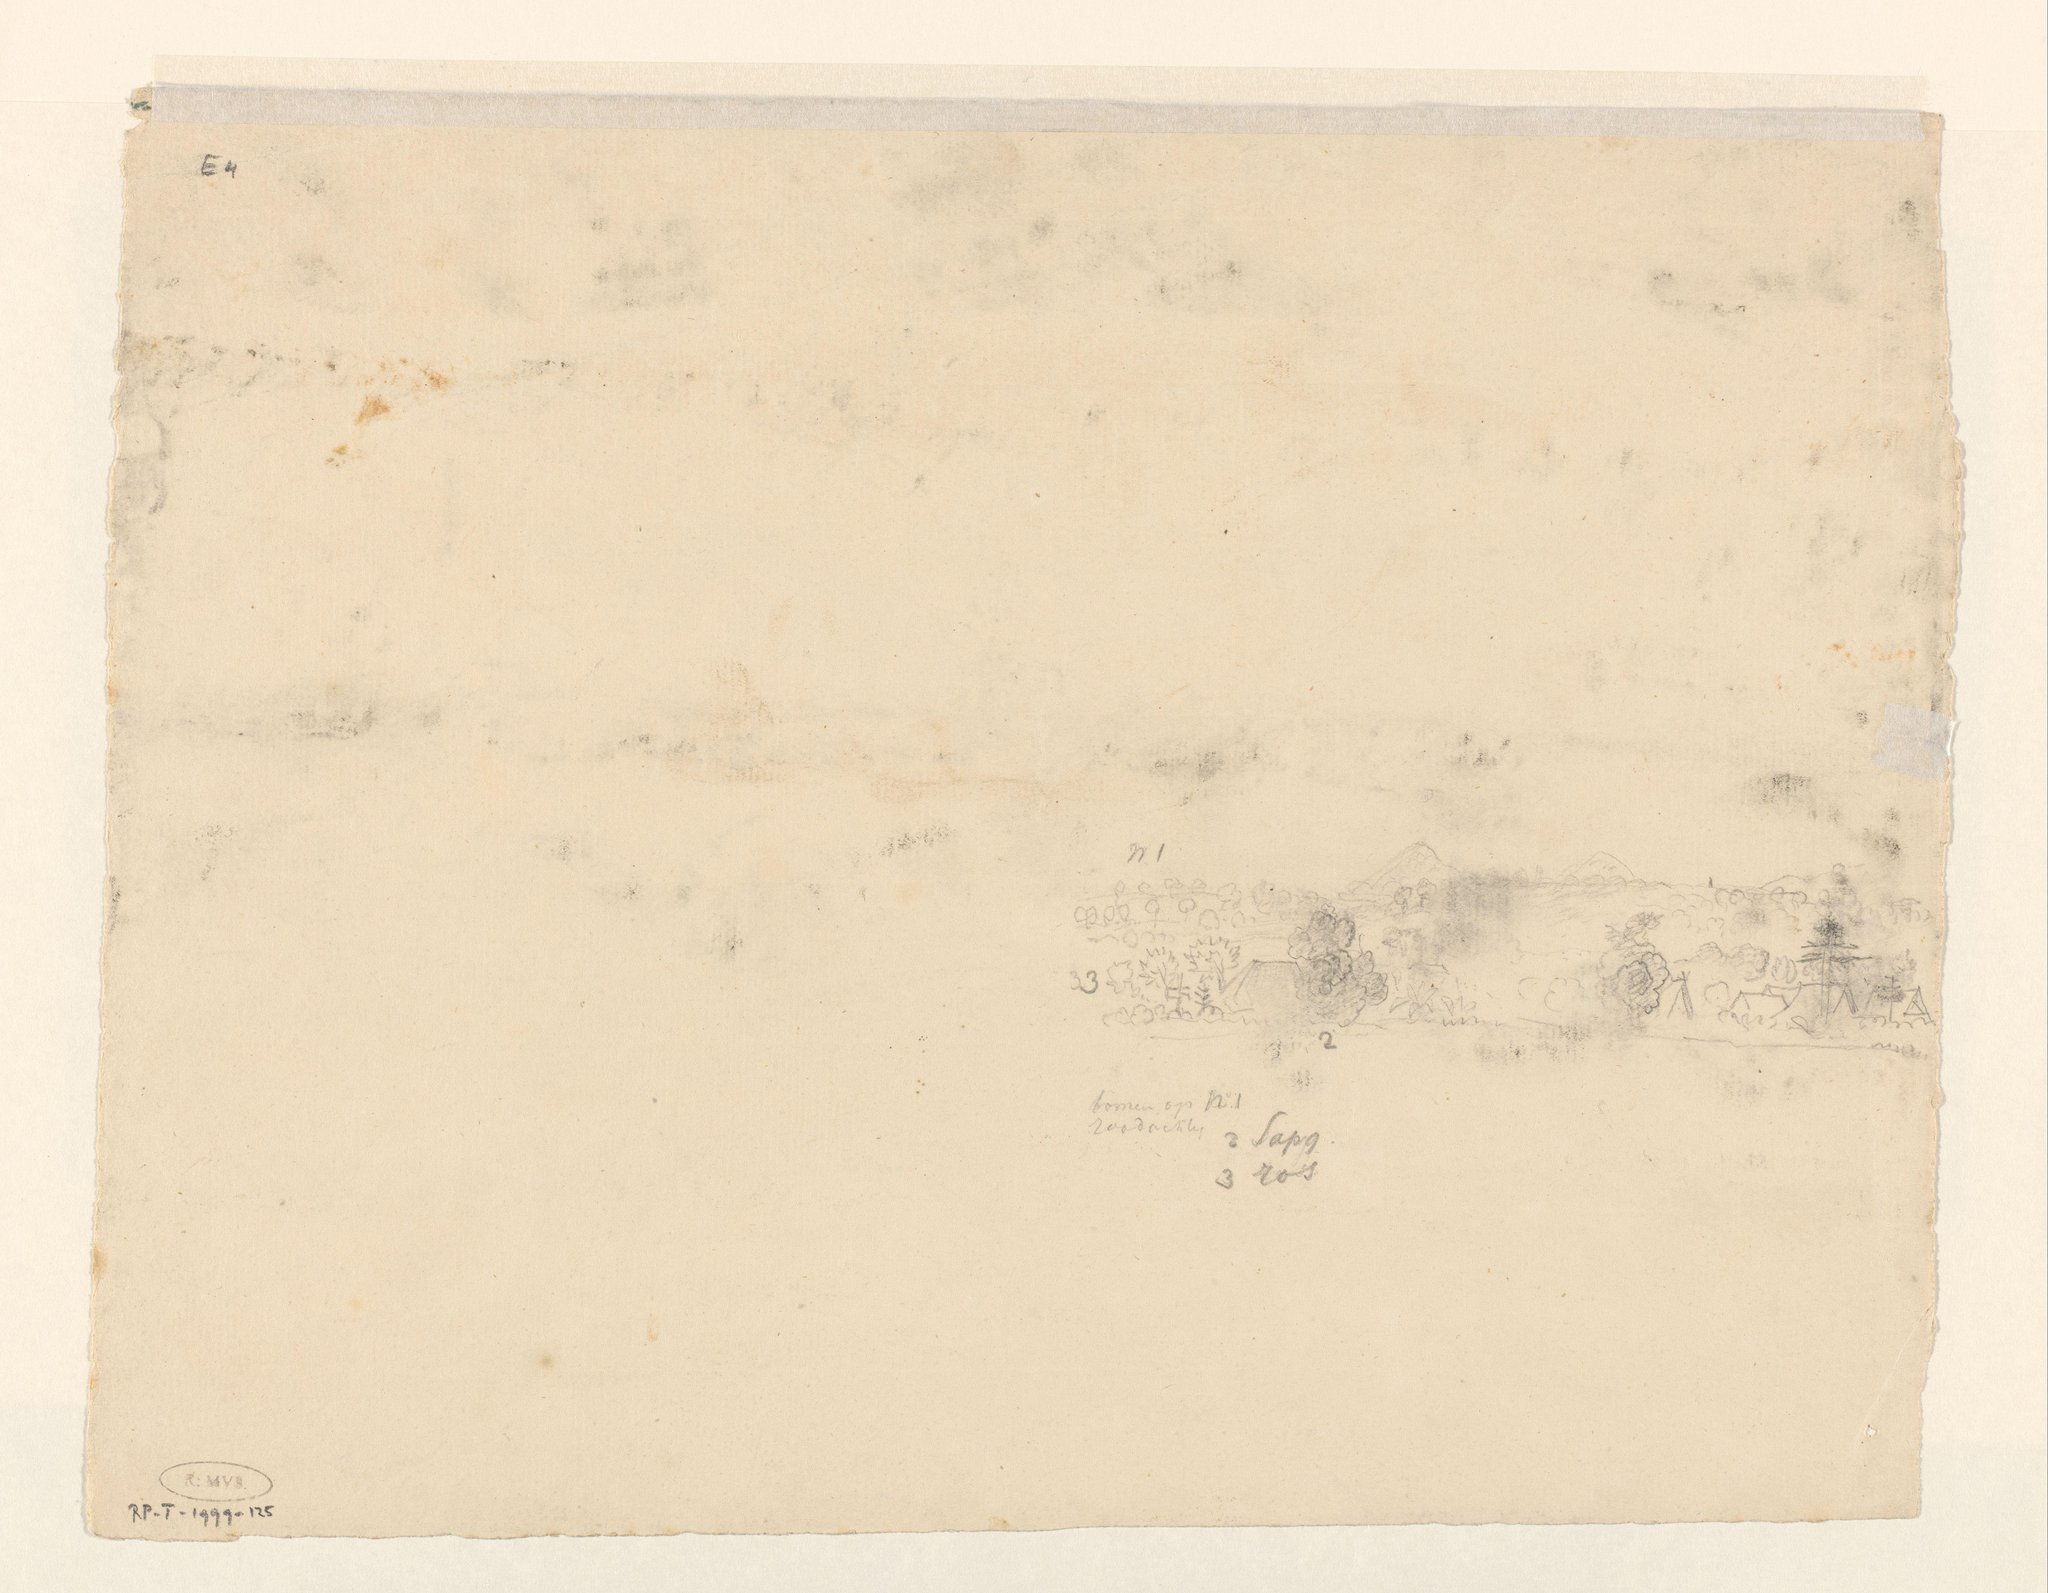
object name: topographical view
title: Dorp verscholen in vegetatie, Java (?)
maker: adrianus johannes bik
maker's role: draughtsman, print maker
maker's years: 1790-1872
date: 1816-1846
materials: paper, pencil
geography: java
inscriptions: annotation: ‘zon, schaduw, kleur van een boom’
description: artikel over deze collectie in Bulletin van het Rijksmuseum 49 [2001], nr. 4, pp 342 e.v., p. 352, afb. 10